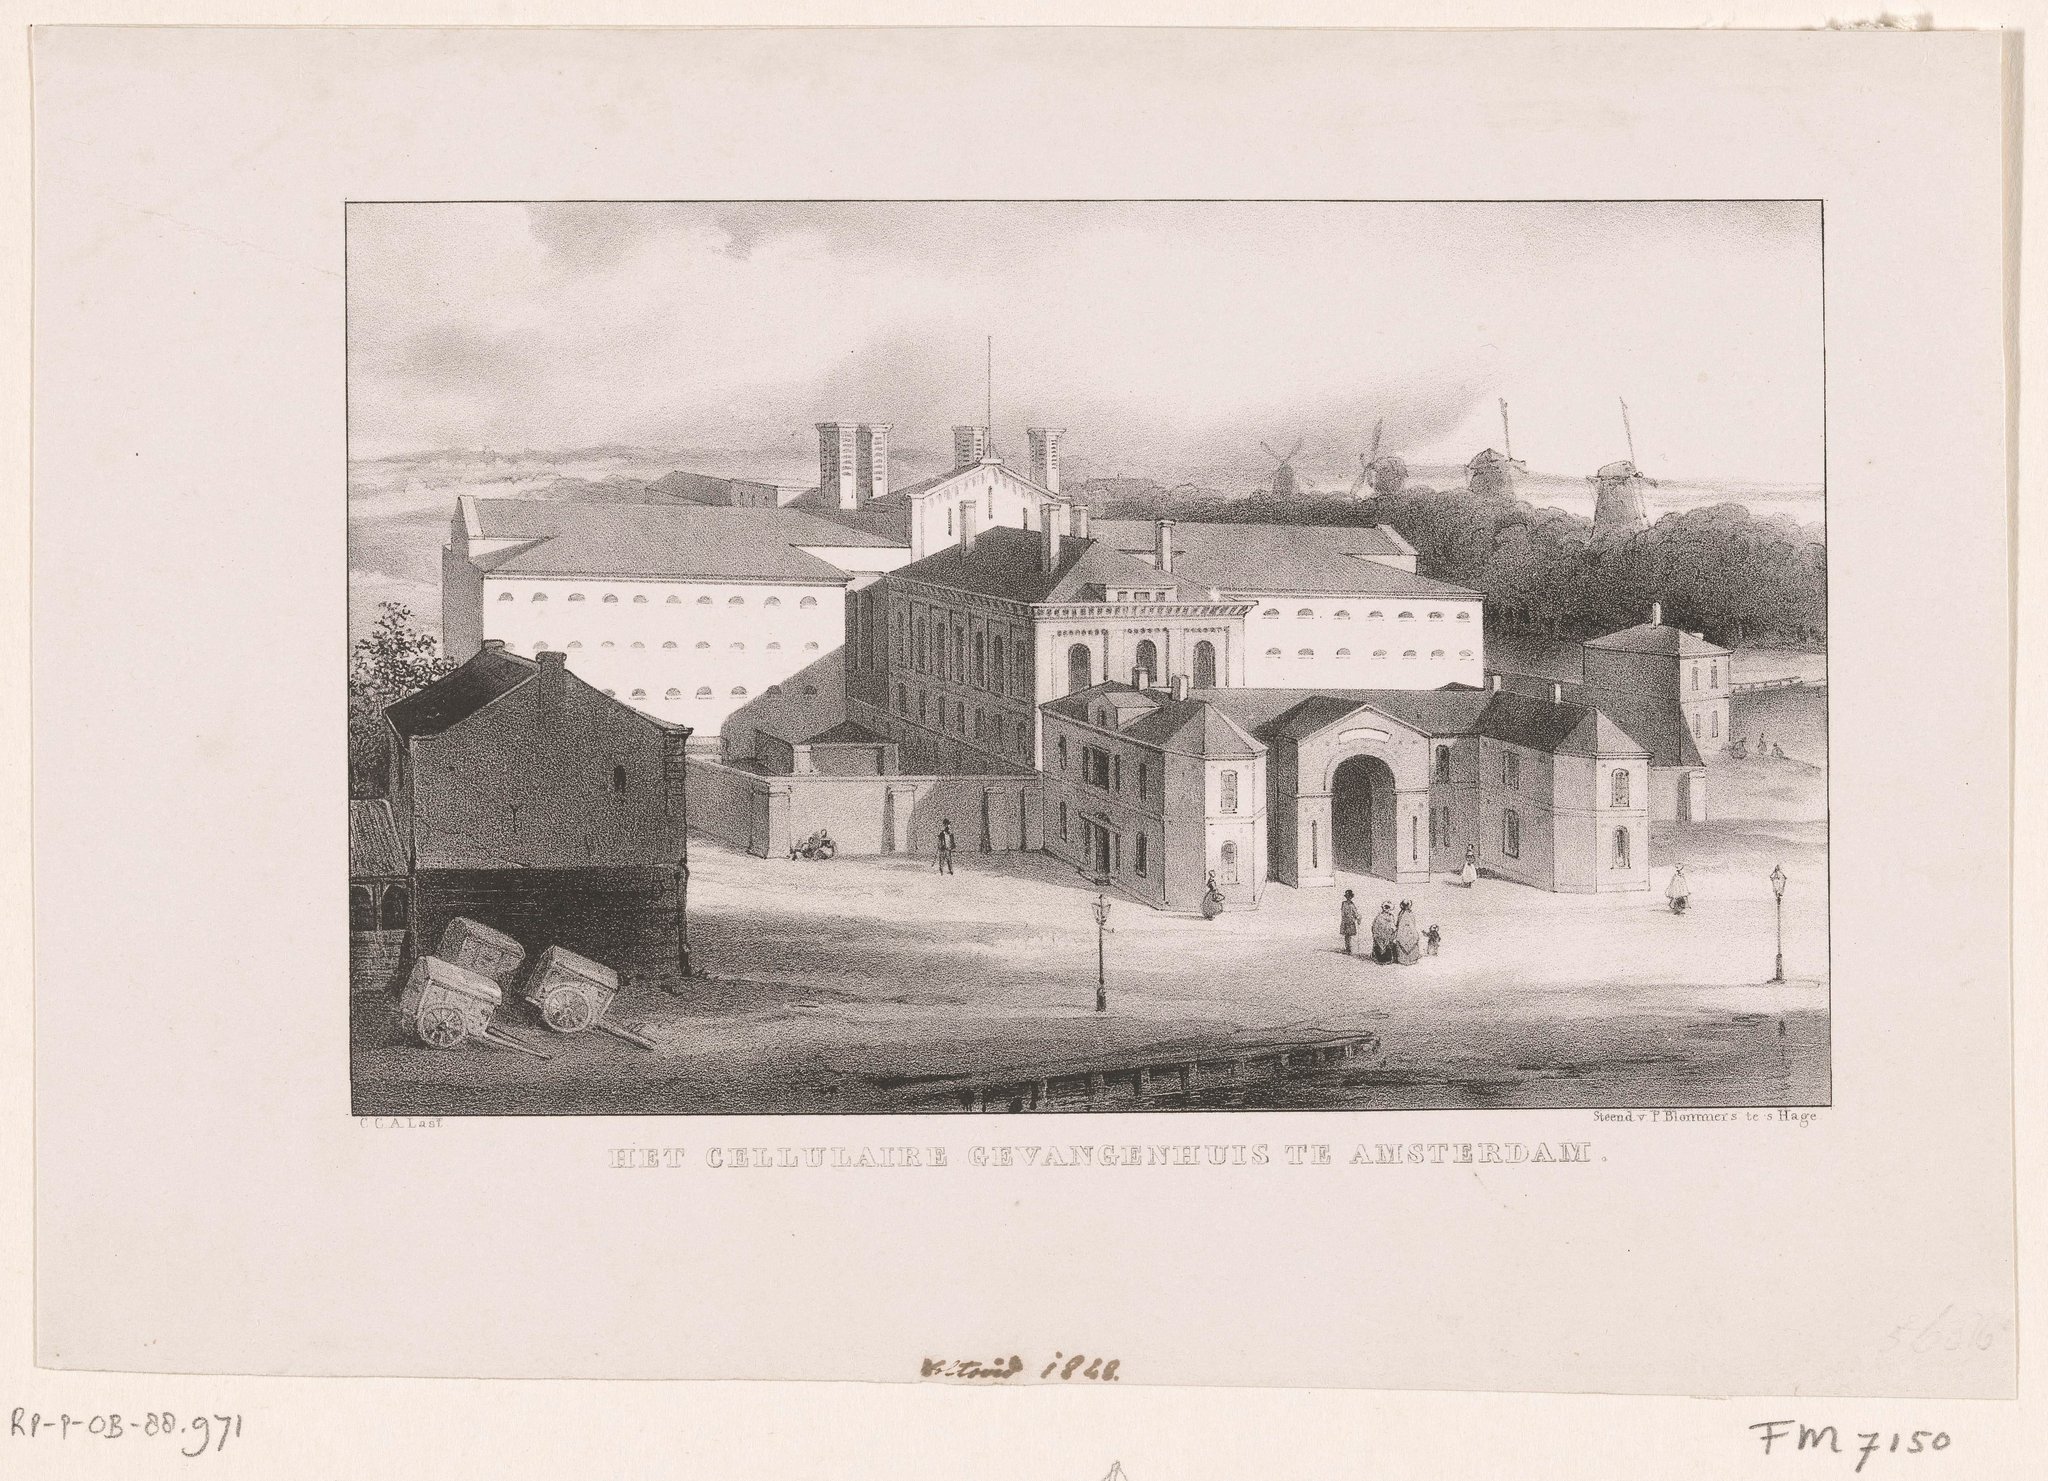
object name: print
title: Gevangenis aan de Weteringschans te Amsterdam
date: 1847-1848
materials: paper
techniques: lithograph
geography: the hague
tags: prison, jail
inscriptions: collector's mark: Lugt 2228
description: Gezicht op het net voltooide Huis van Bewaring aan de Weteringschans te Amsterdam, 1848. Zie ook de pendant.